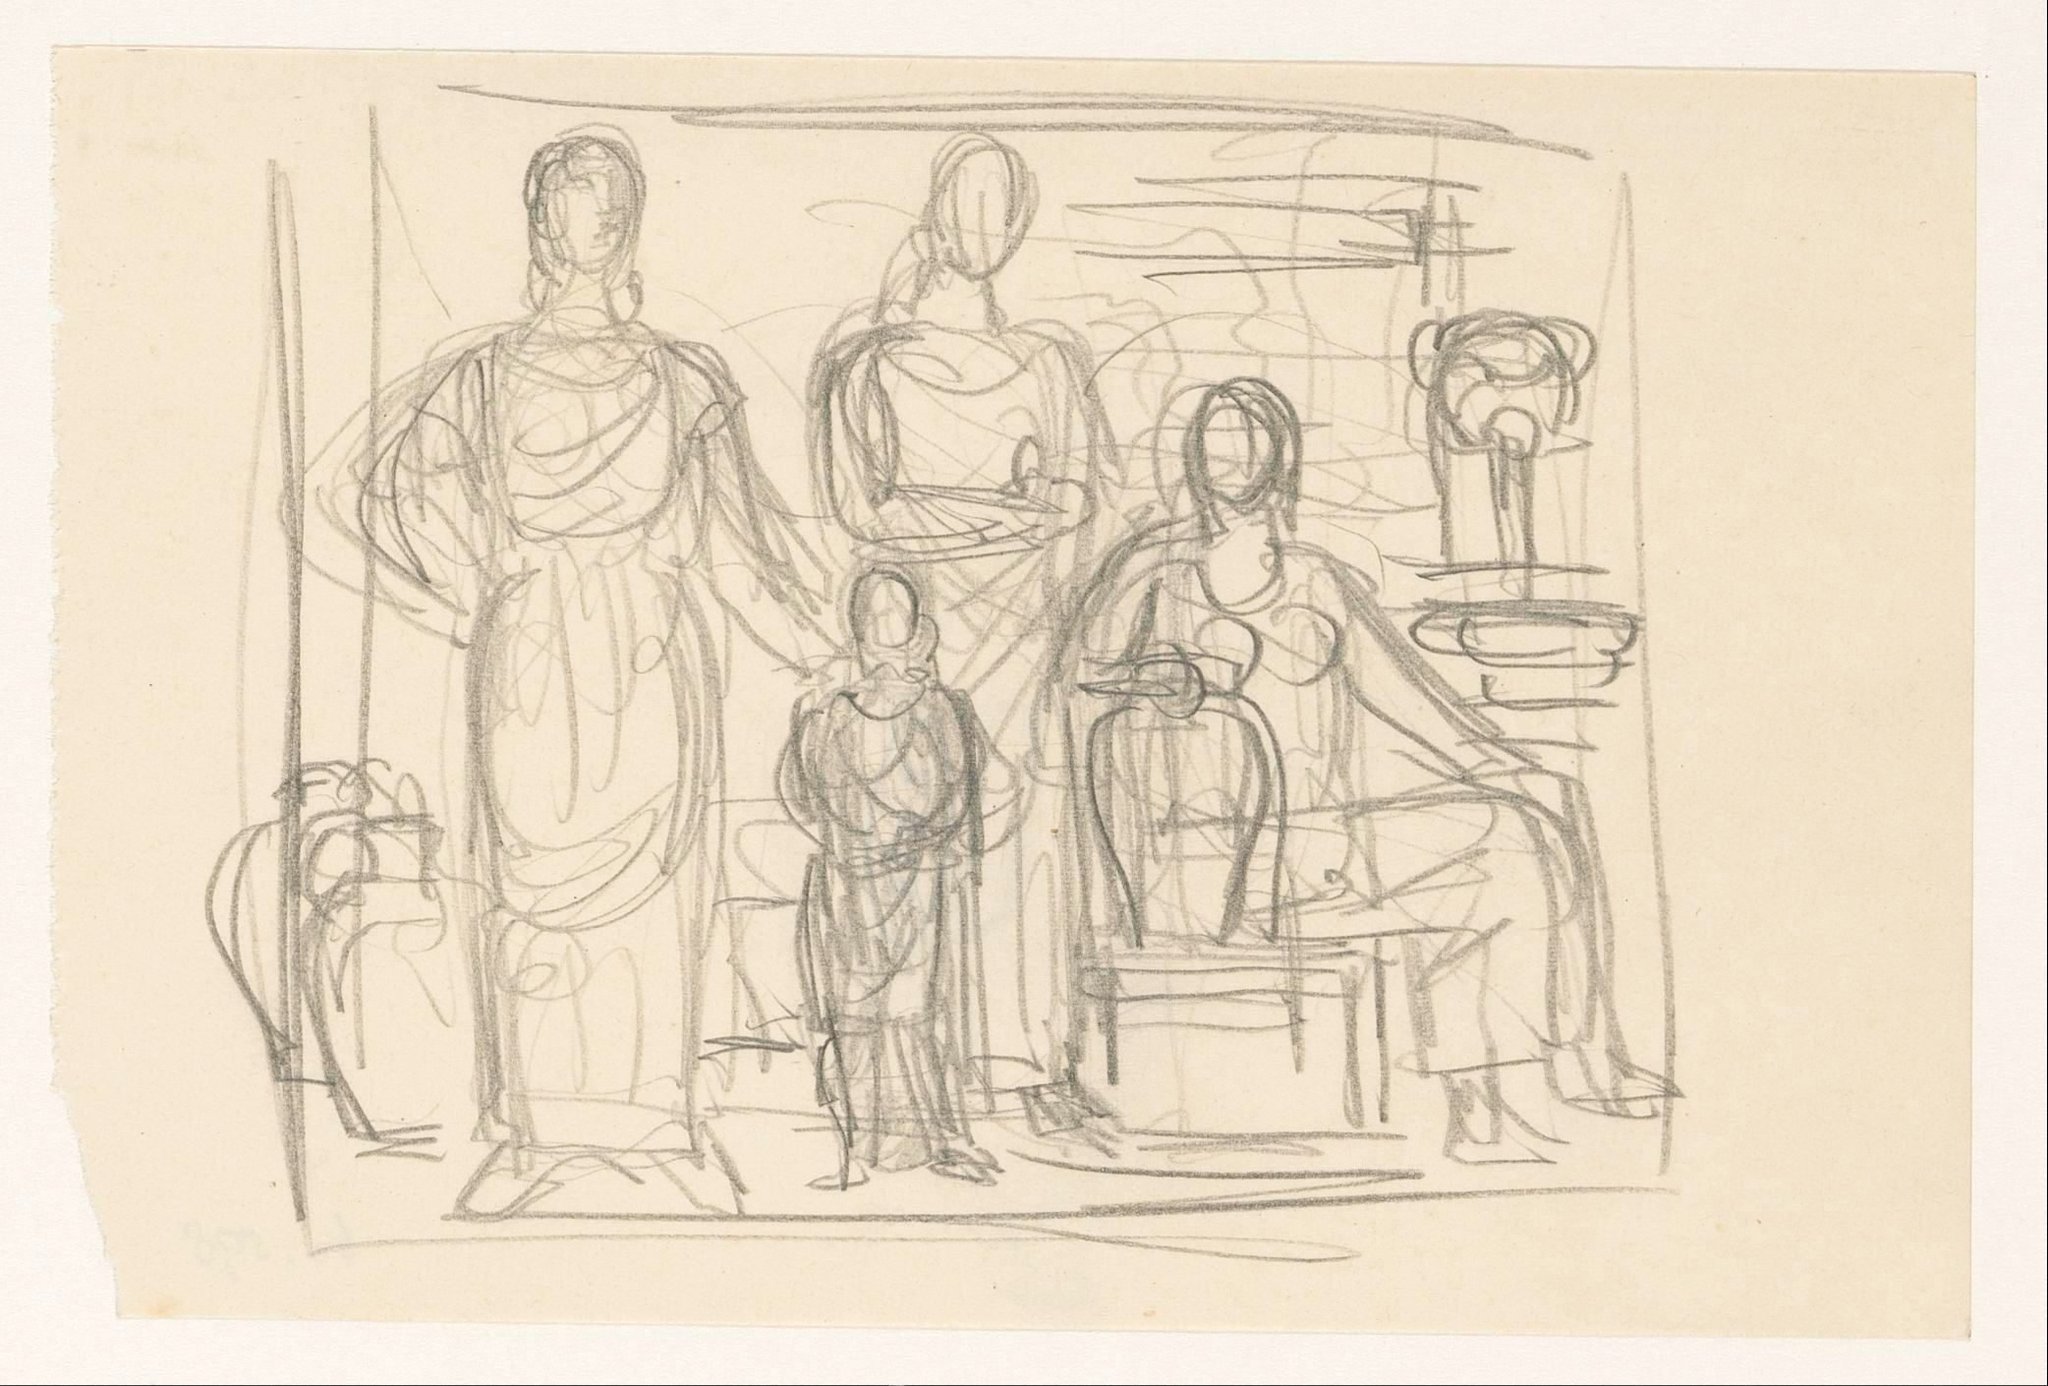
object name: drawing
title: Vier personen bij een waterbron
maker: leo gestel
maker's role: draughtsman, print maker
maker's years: 1881-1941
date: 1891-1941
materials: paper, pencil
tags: well, standing figure, sitting figure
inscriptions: collector's mark: Lugt 2228